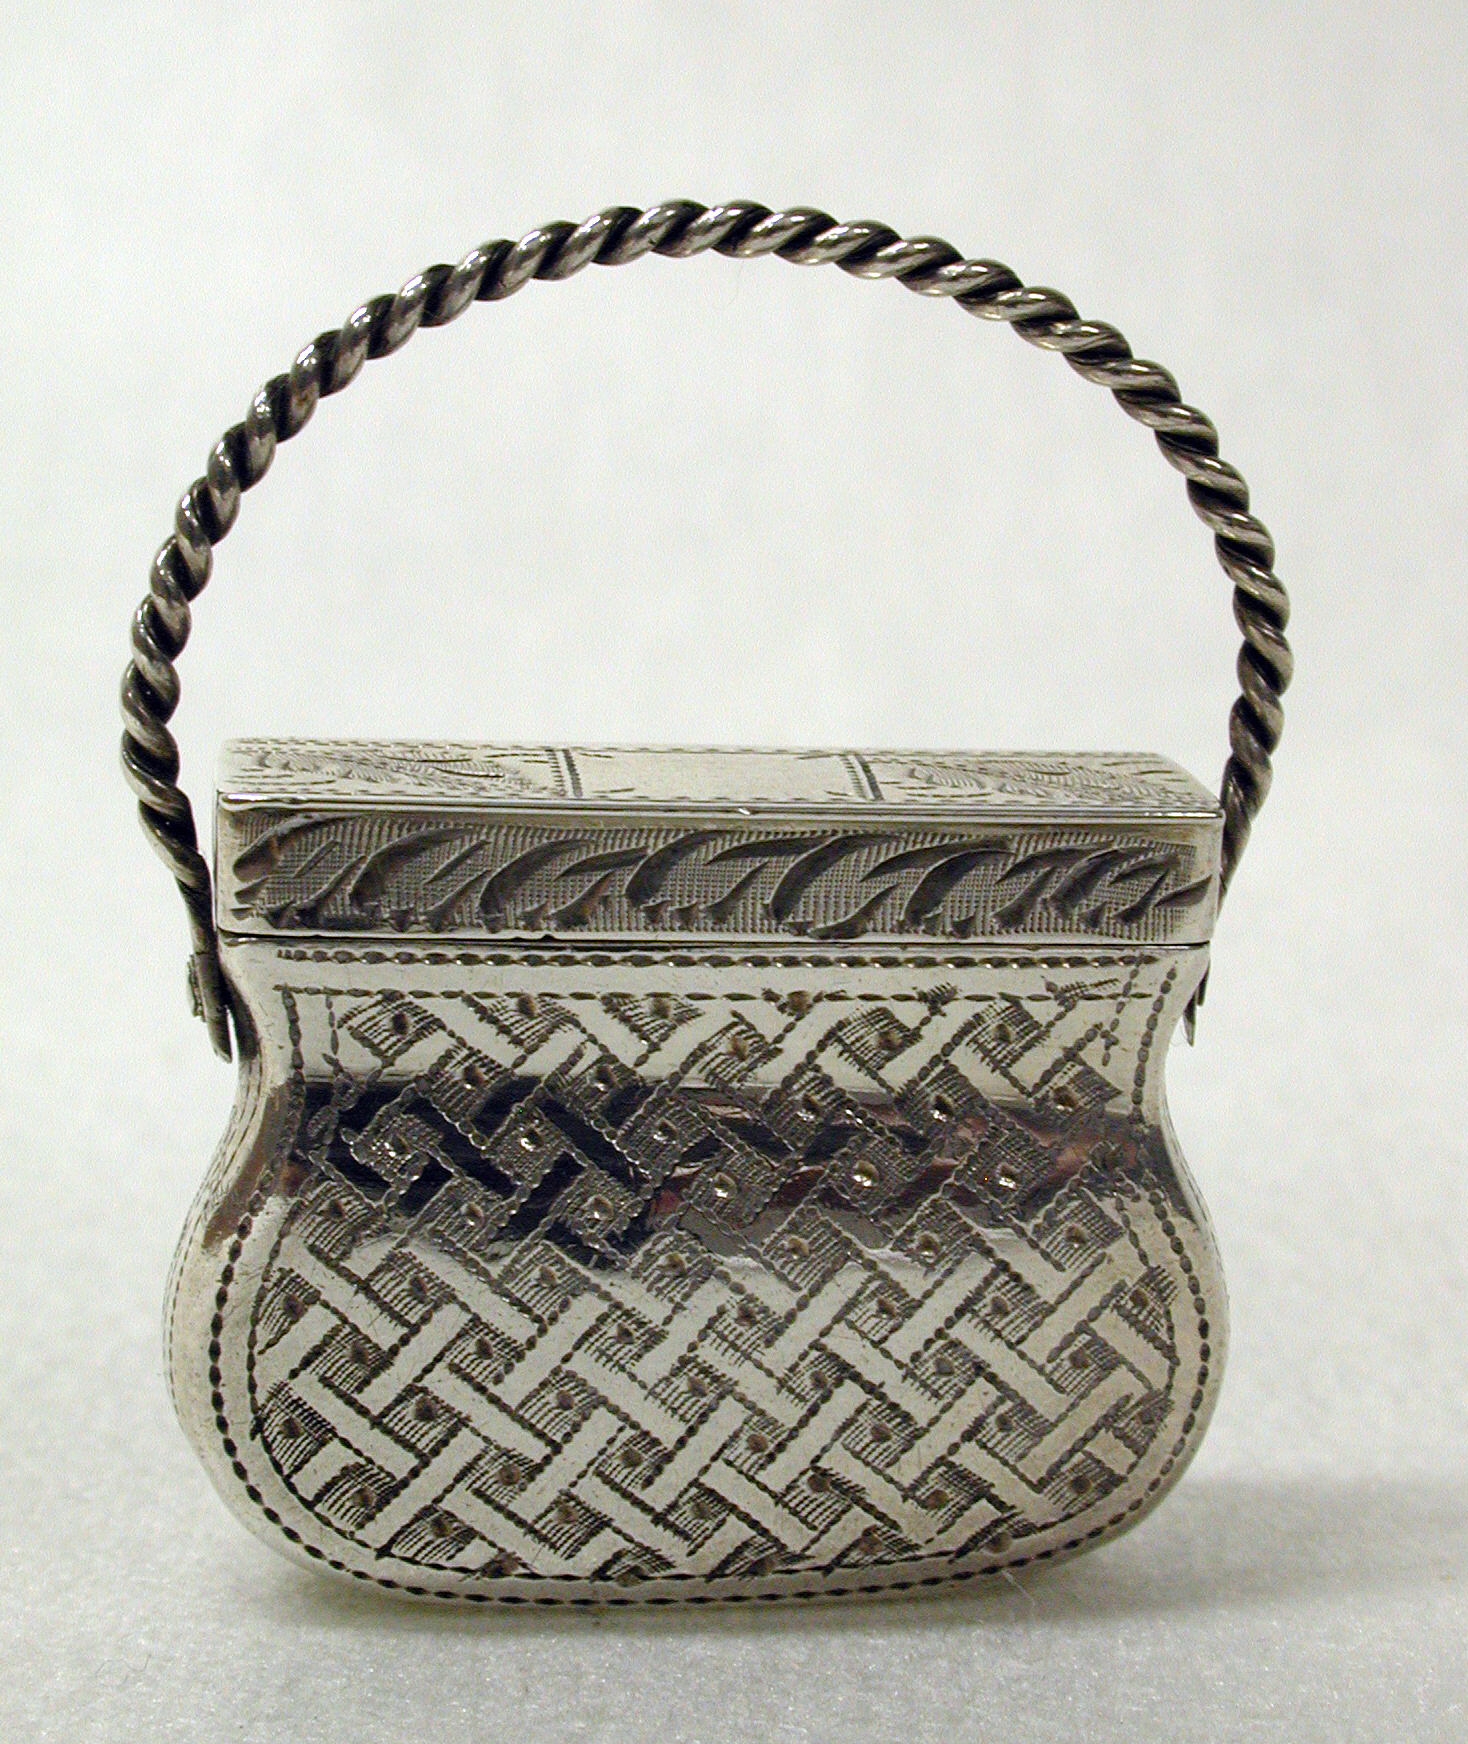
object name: vinaigrette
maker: gervase wheeler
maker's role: maker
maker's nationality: british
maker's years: 1831-1875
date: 1829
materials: silver